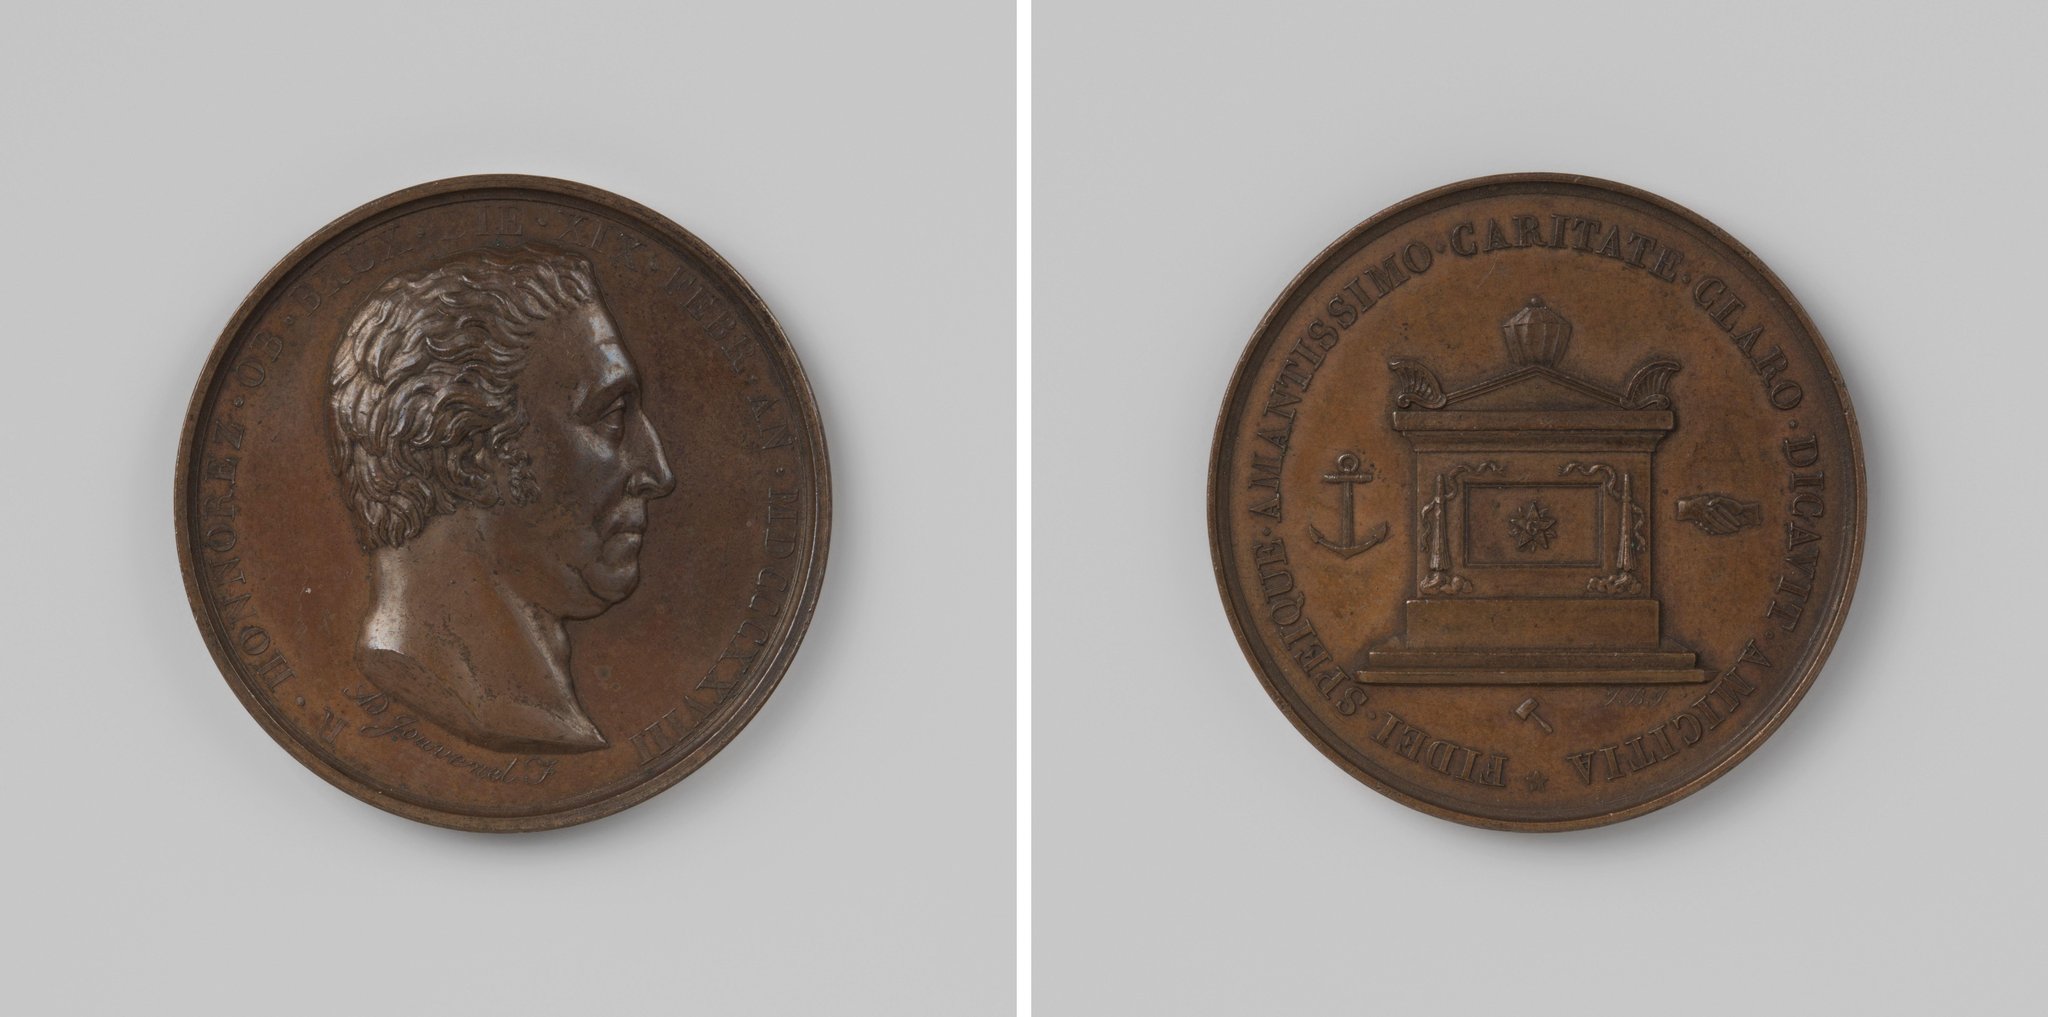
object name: history medal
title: Overlijden van R. Honnorez, Grootarchivaris van de "Grande Loge d'Administration" te Brussel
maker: jean-baptiste clément jouvenel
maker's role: print maker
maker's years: 1773-1846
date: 1828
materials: bronze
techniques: striking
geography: brussels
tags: brussels